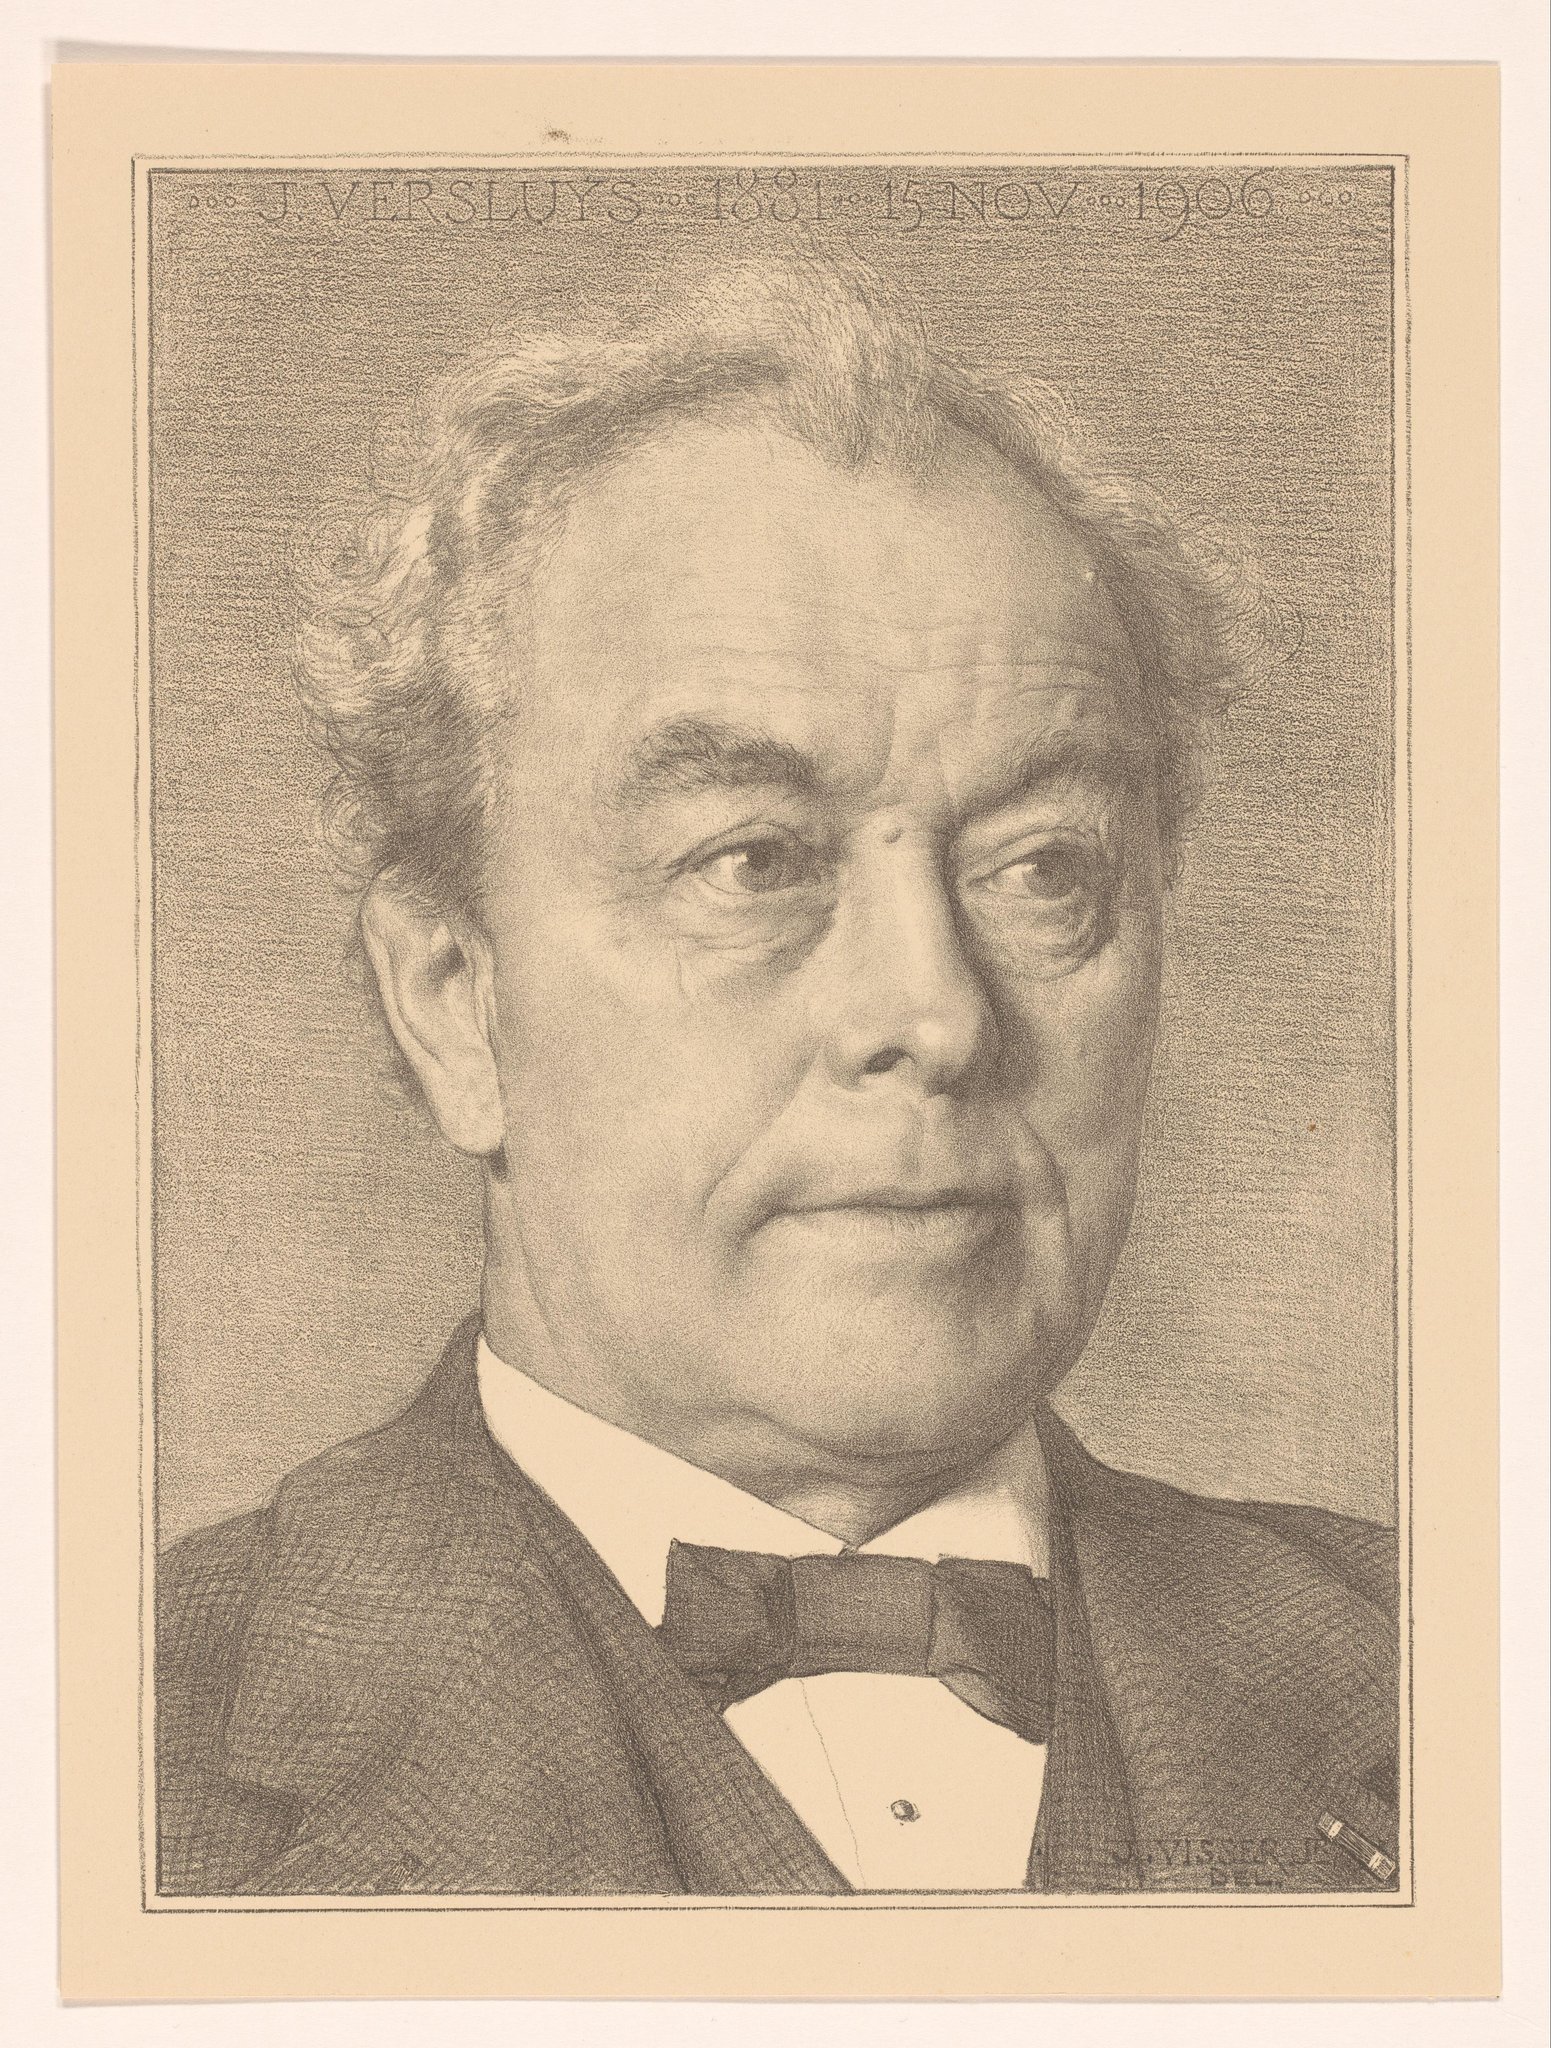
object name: print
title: Portret van J. Versluys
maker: jan visser (1856-1938)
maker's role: print maker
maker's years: 1856-1938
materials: paper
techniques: lithograph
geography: netherlands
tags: historical persons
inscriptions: collector's mark: Lugt 2228